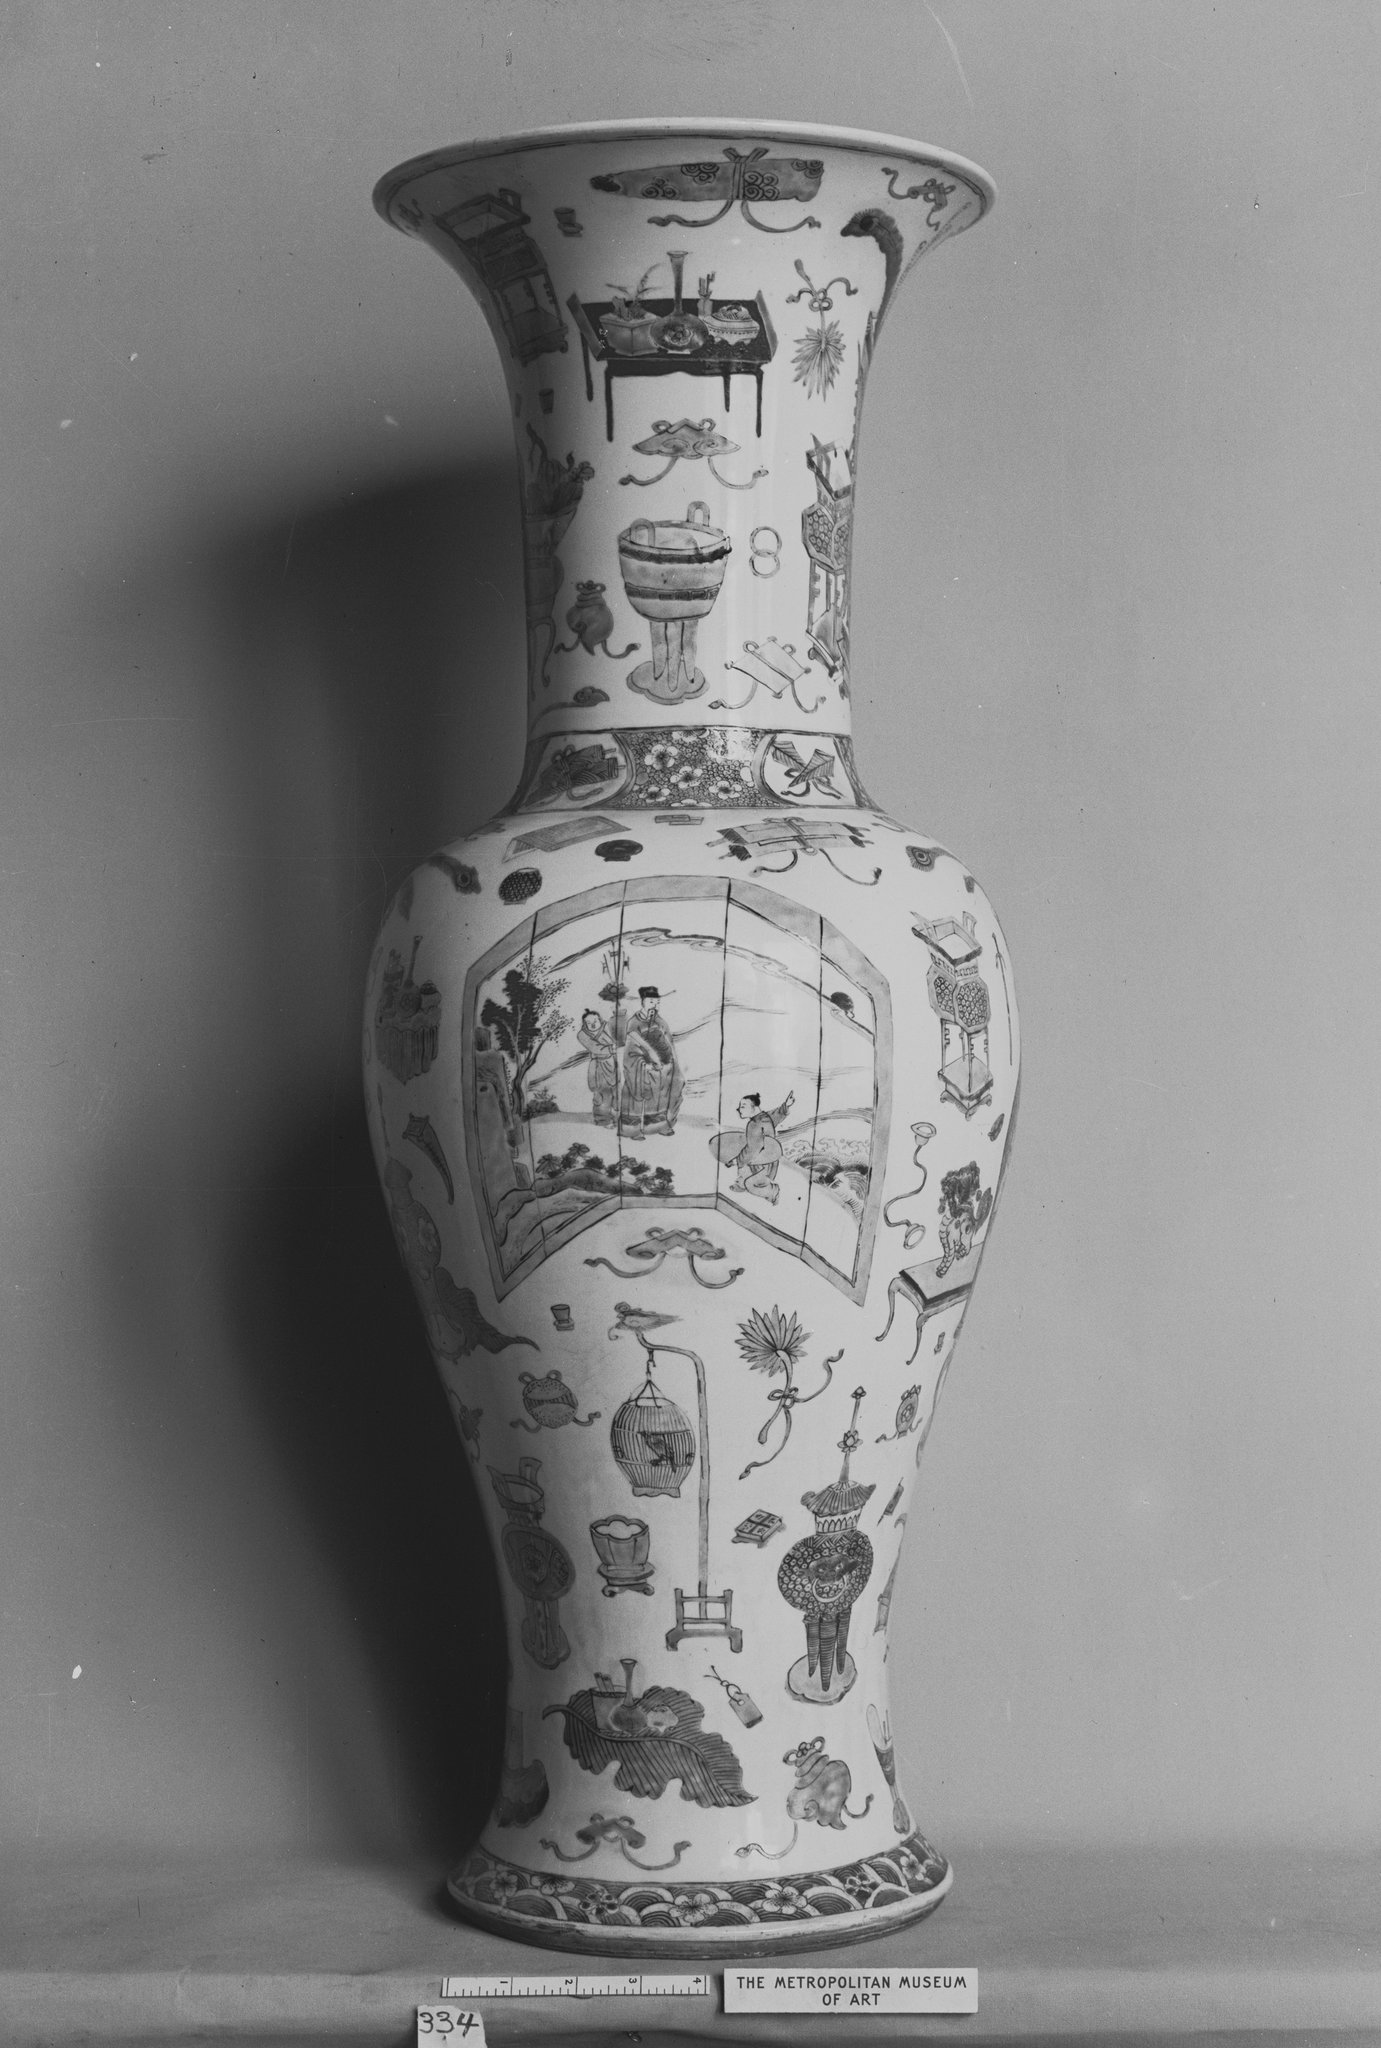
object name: vase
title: Vase with design of "Hundred Antiques"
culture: chinese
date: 1667-1733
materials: enamel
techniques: overglaze, painting, polychrome